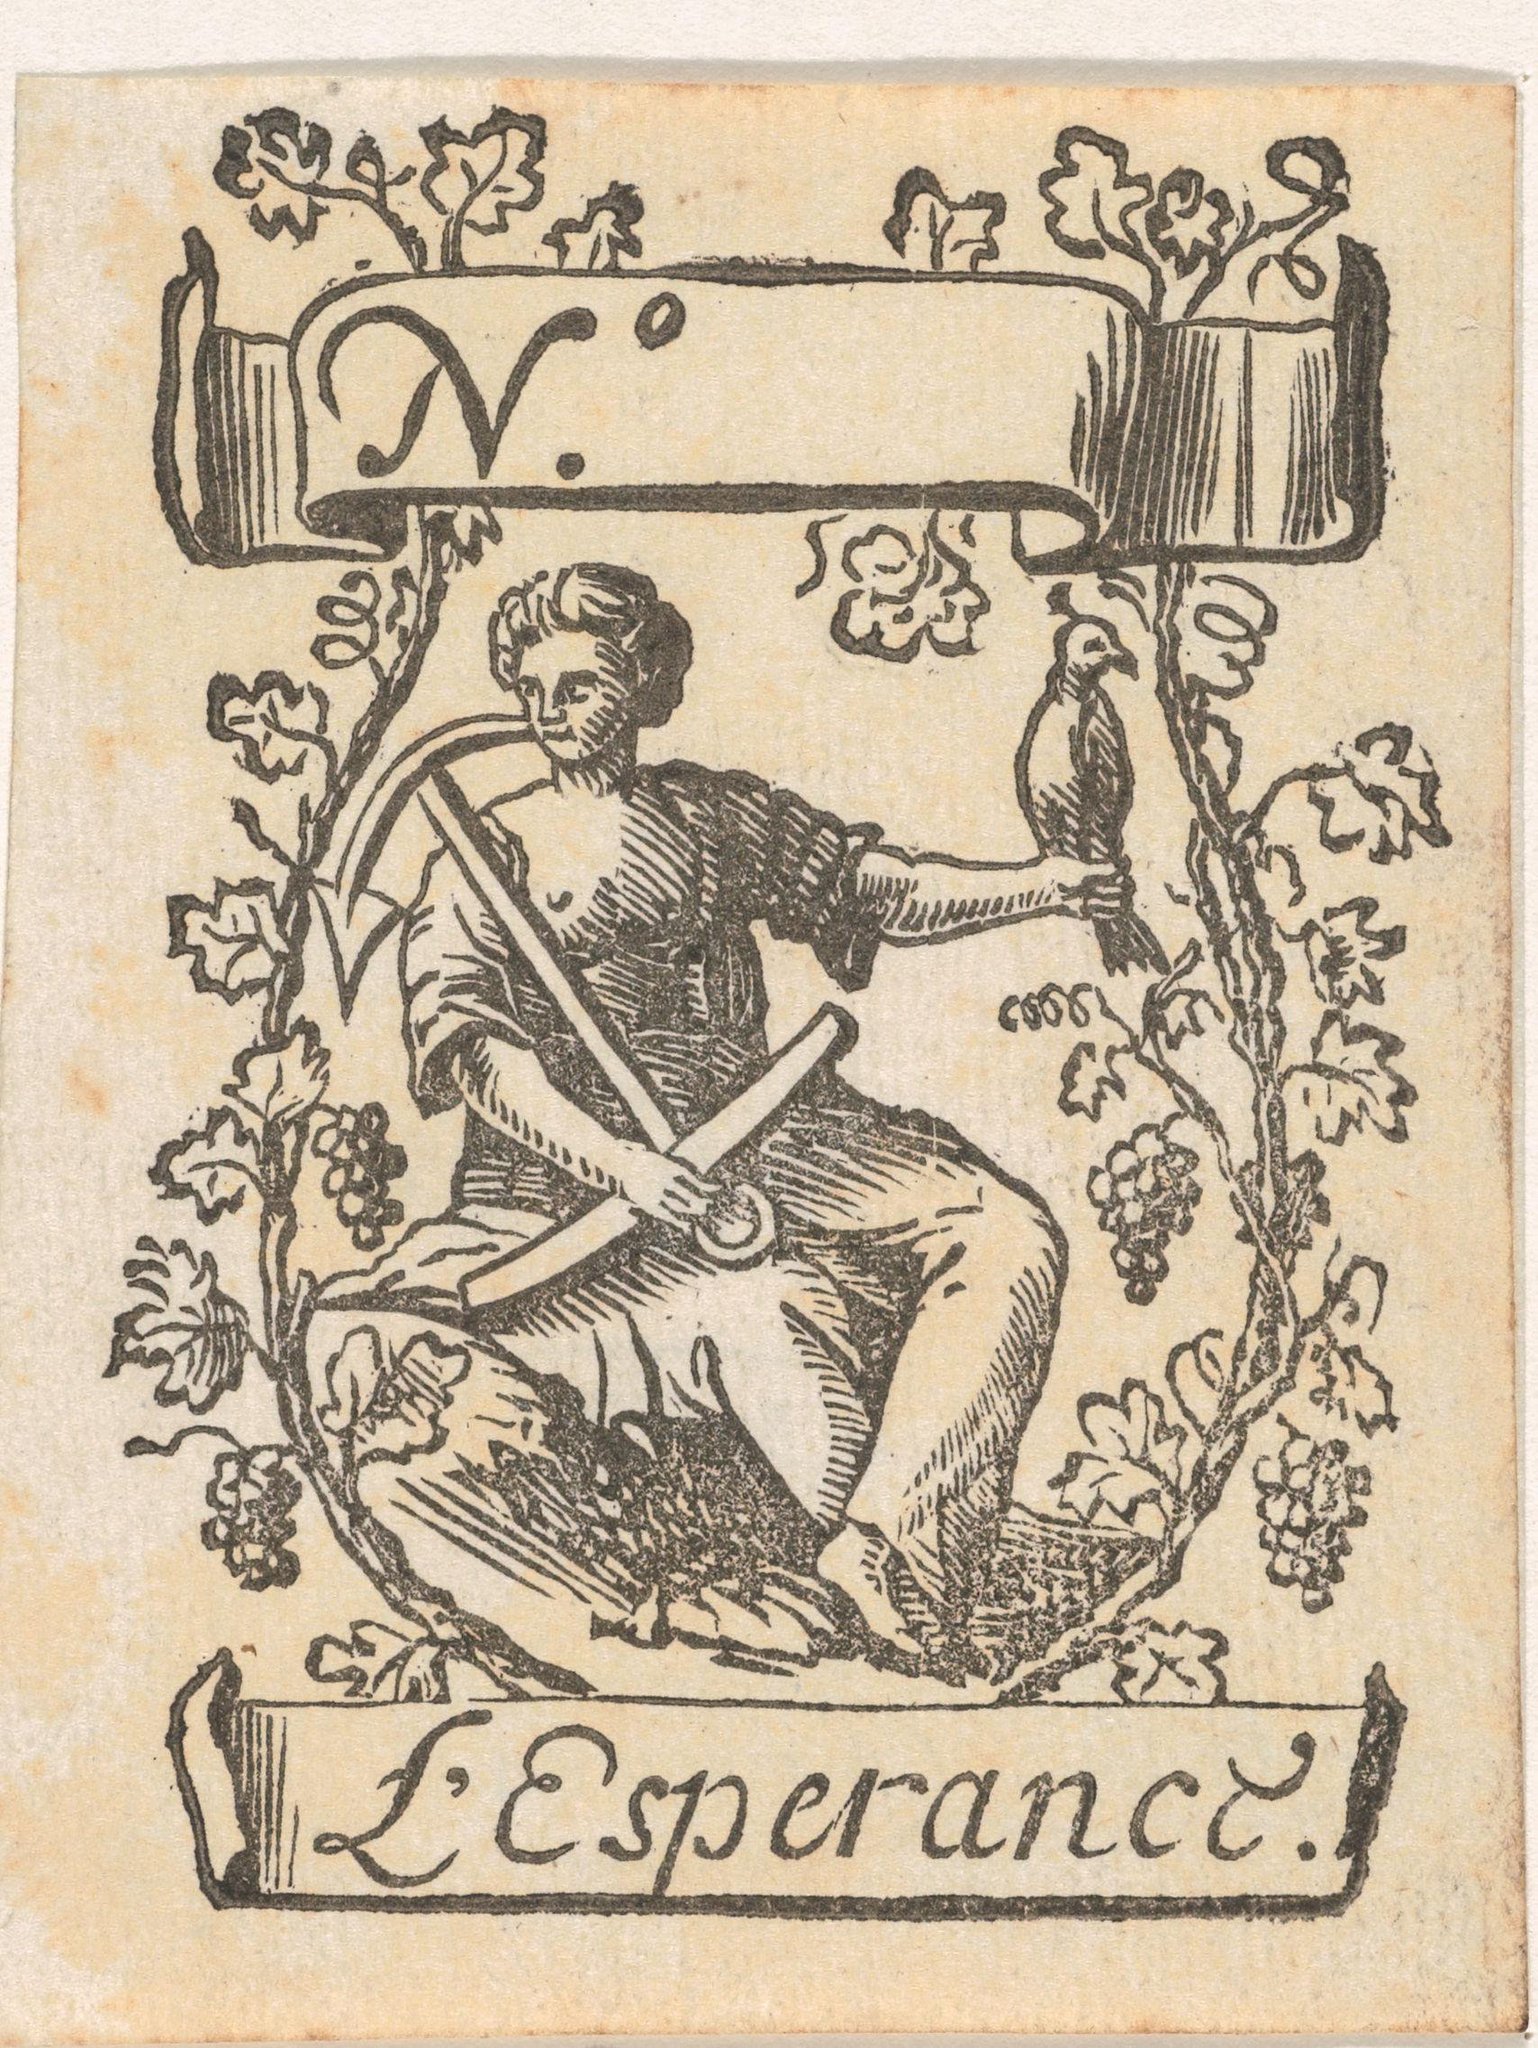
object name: print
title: Handelsetiket met Hoop die een anker en een vogel vasthoudt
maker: isaac vincentsz. van der vinne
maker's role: draughtsman, print maker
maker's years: 1665-1740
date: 1681-1740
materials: paper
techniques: woodcut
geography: haarlem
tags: hope, 'spes'; 'speranza divina e certa' (ripa) ~ one of the three theological virtues, vignette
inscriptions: collector's mark: Lugt 2228, collector's mark: Lugt 698